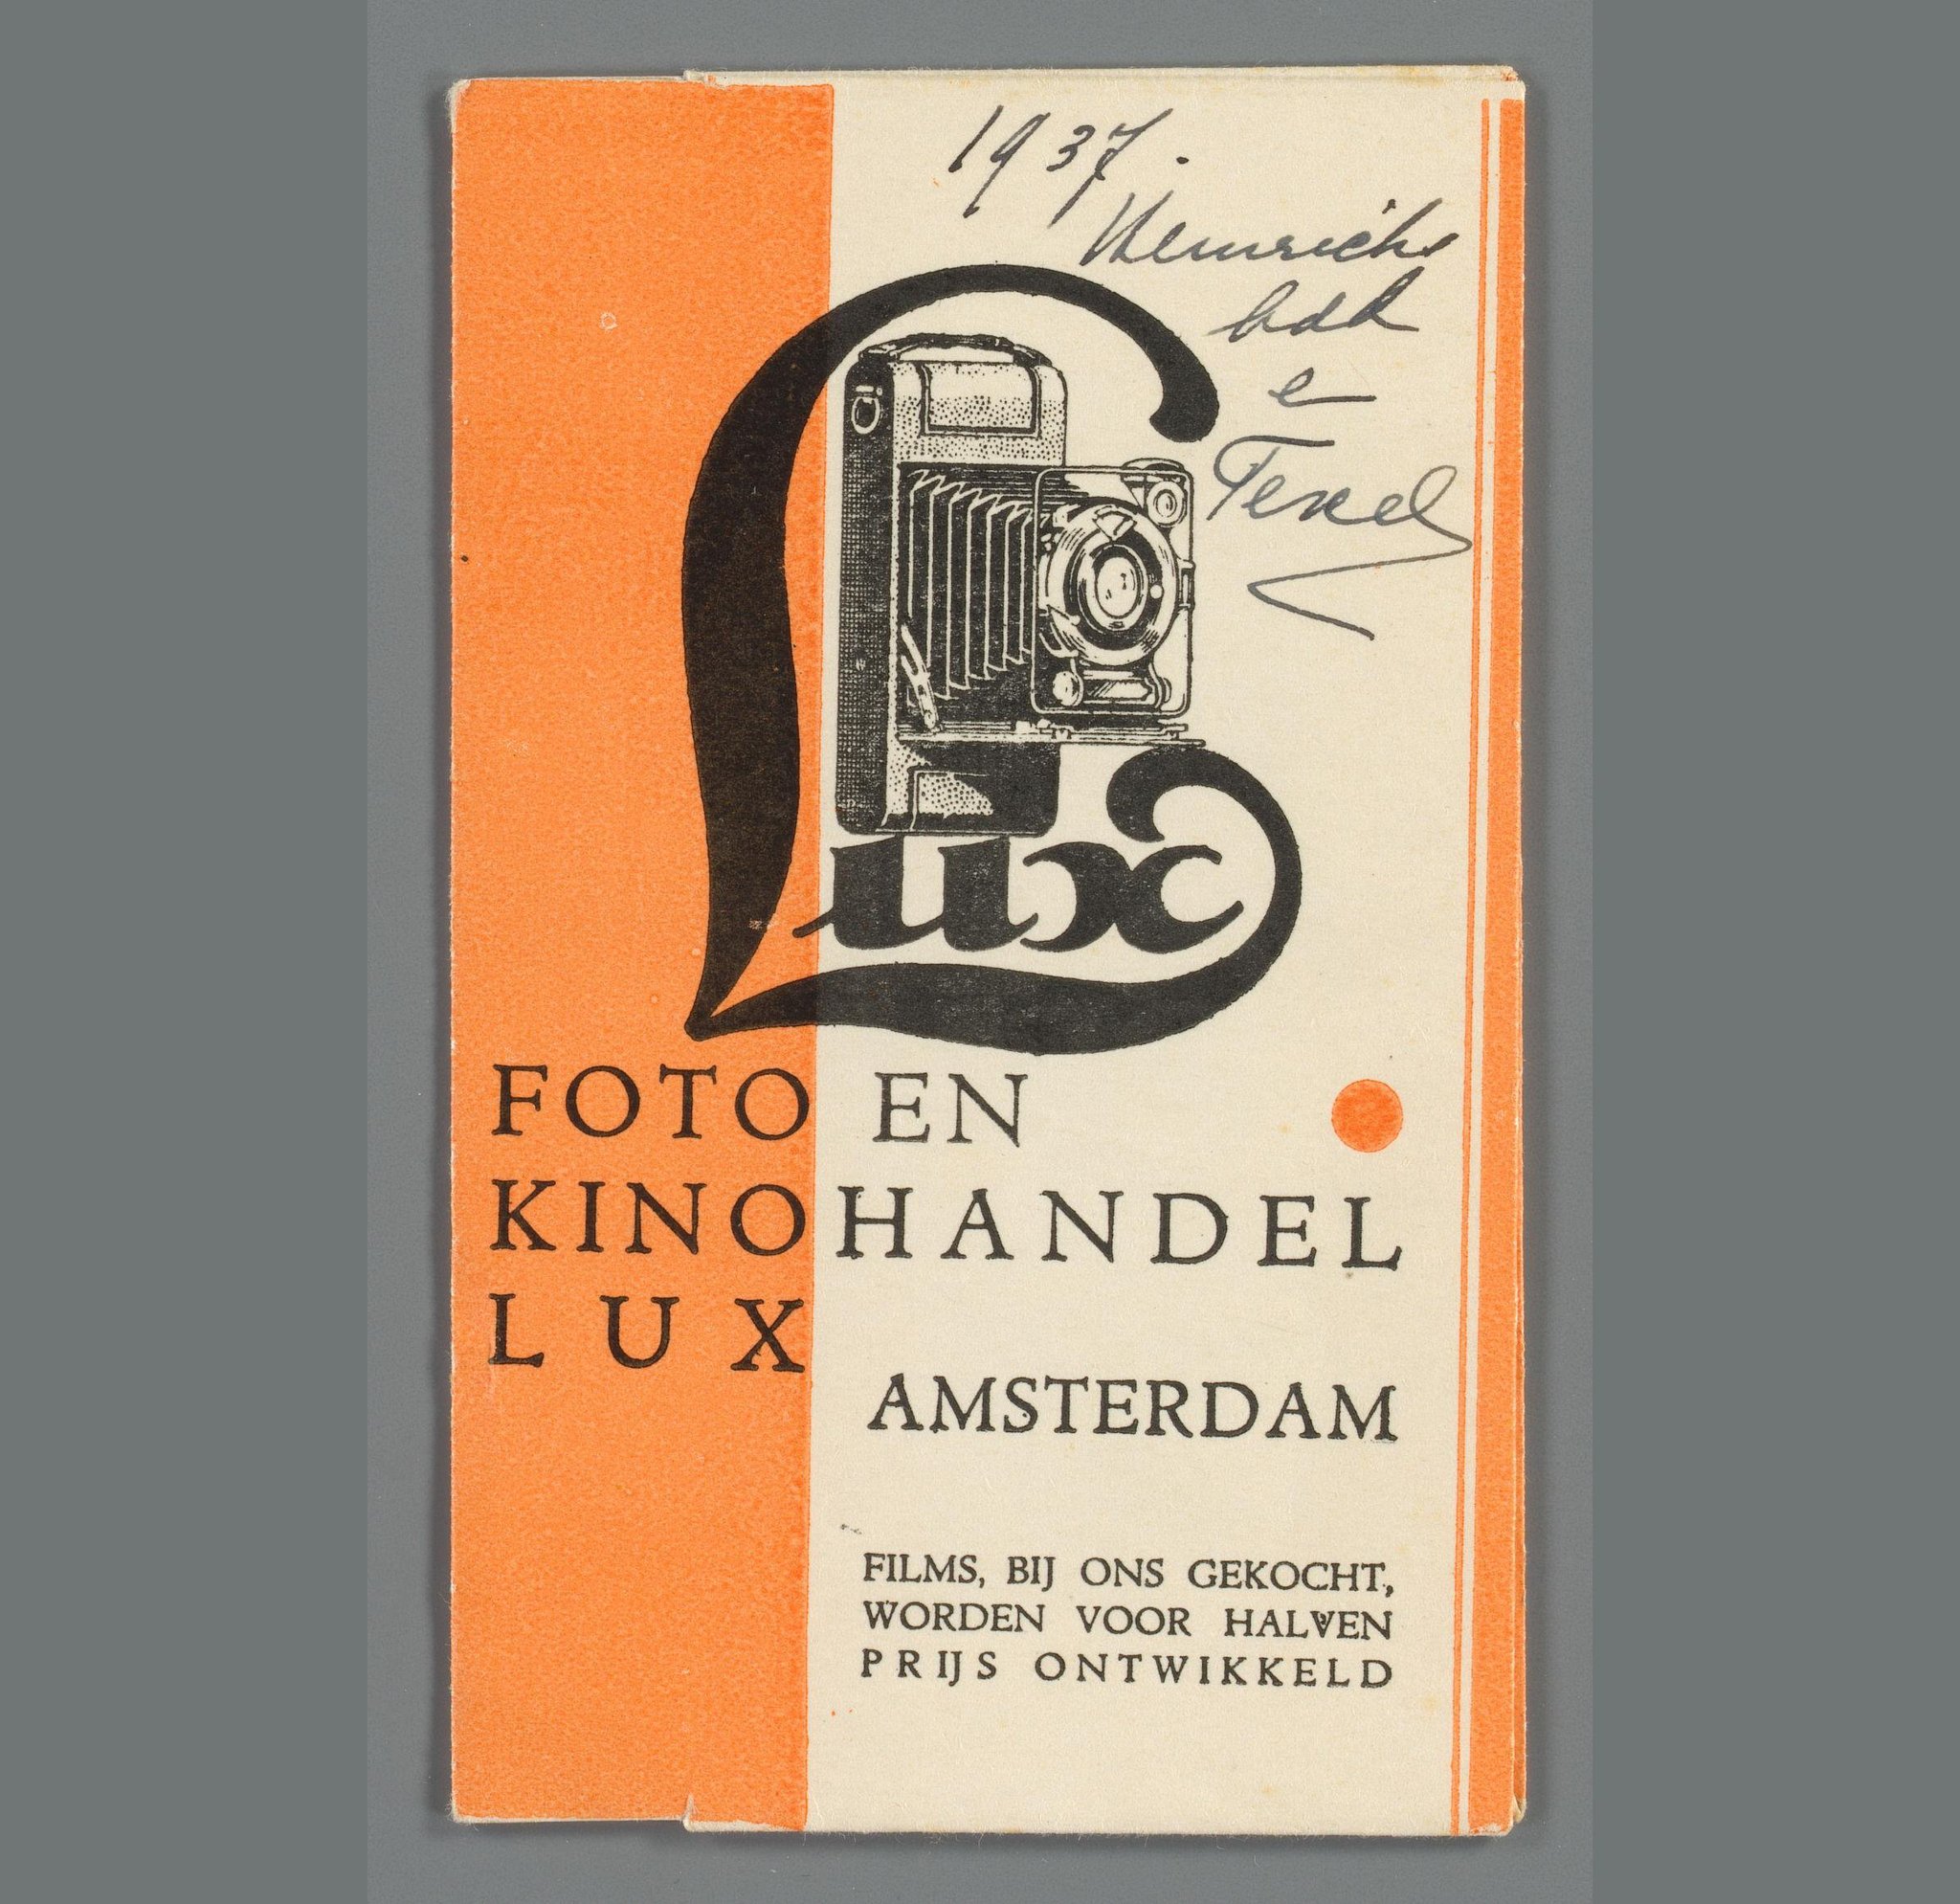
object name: photomap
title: Foto en kinohandel Lux Amsterdam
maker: Anonymous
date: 1937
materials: paper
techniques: letterpress printing, printing block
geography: amsterdam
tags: camera ~ photography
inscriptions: inscription: ‘1937./ Heinrichs/ bad/ en/ Texel’